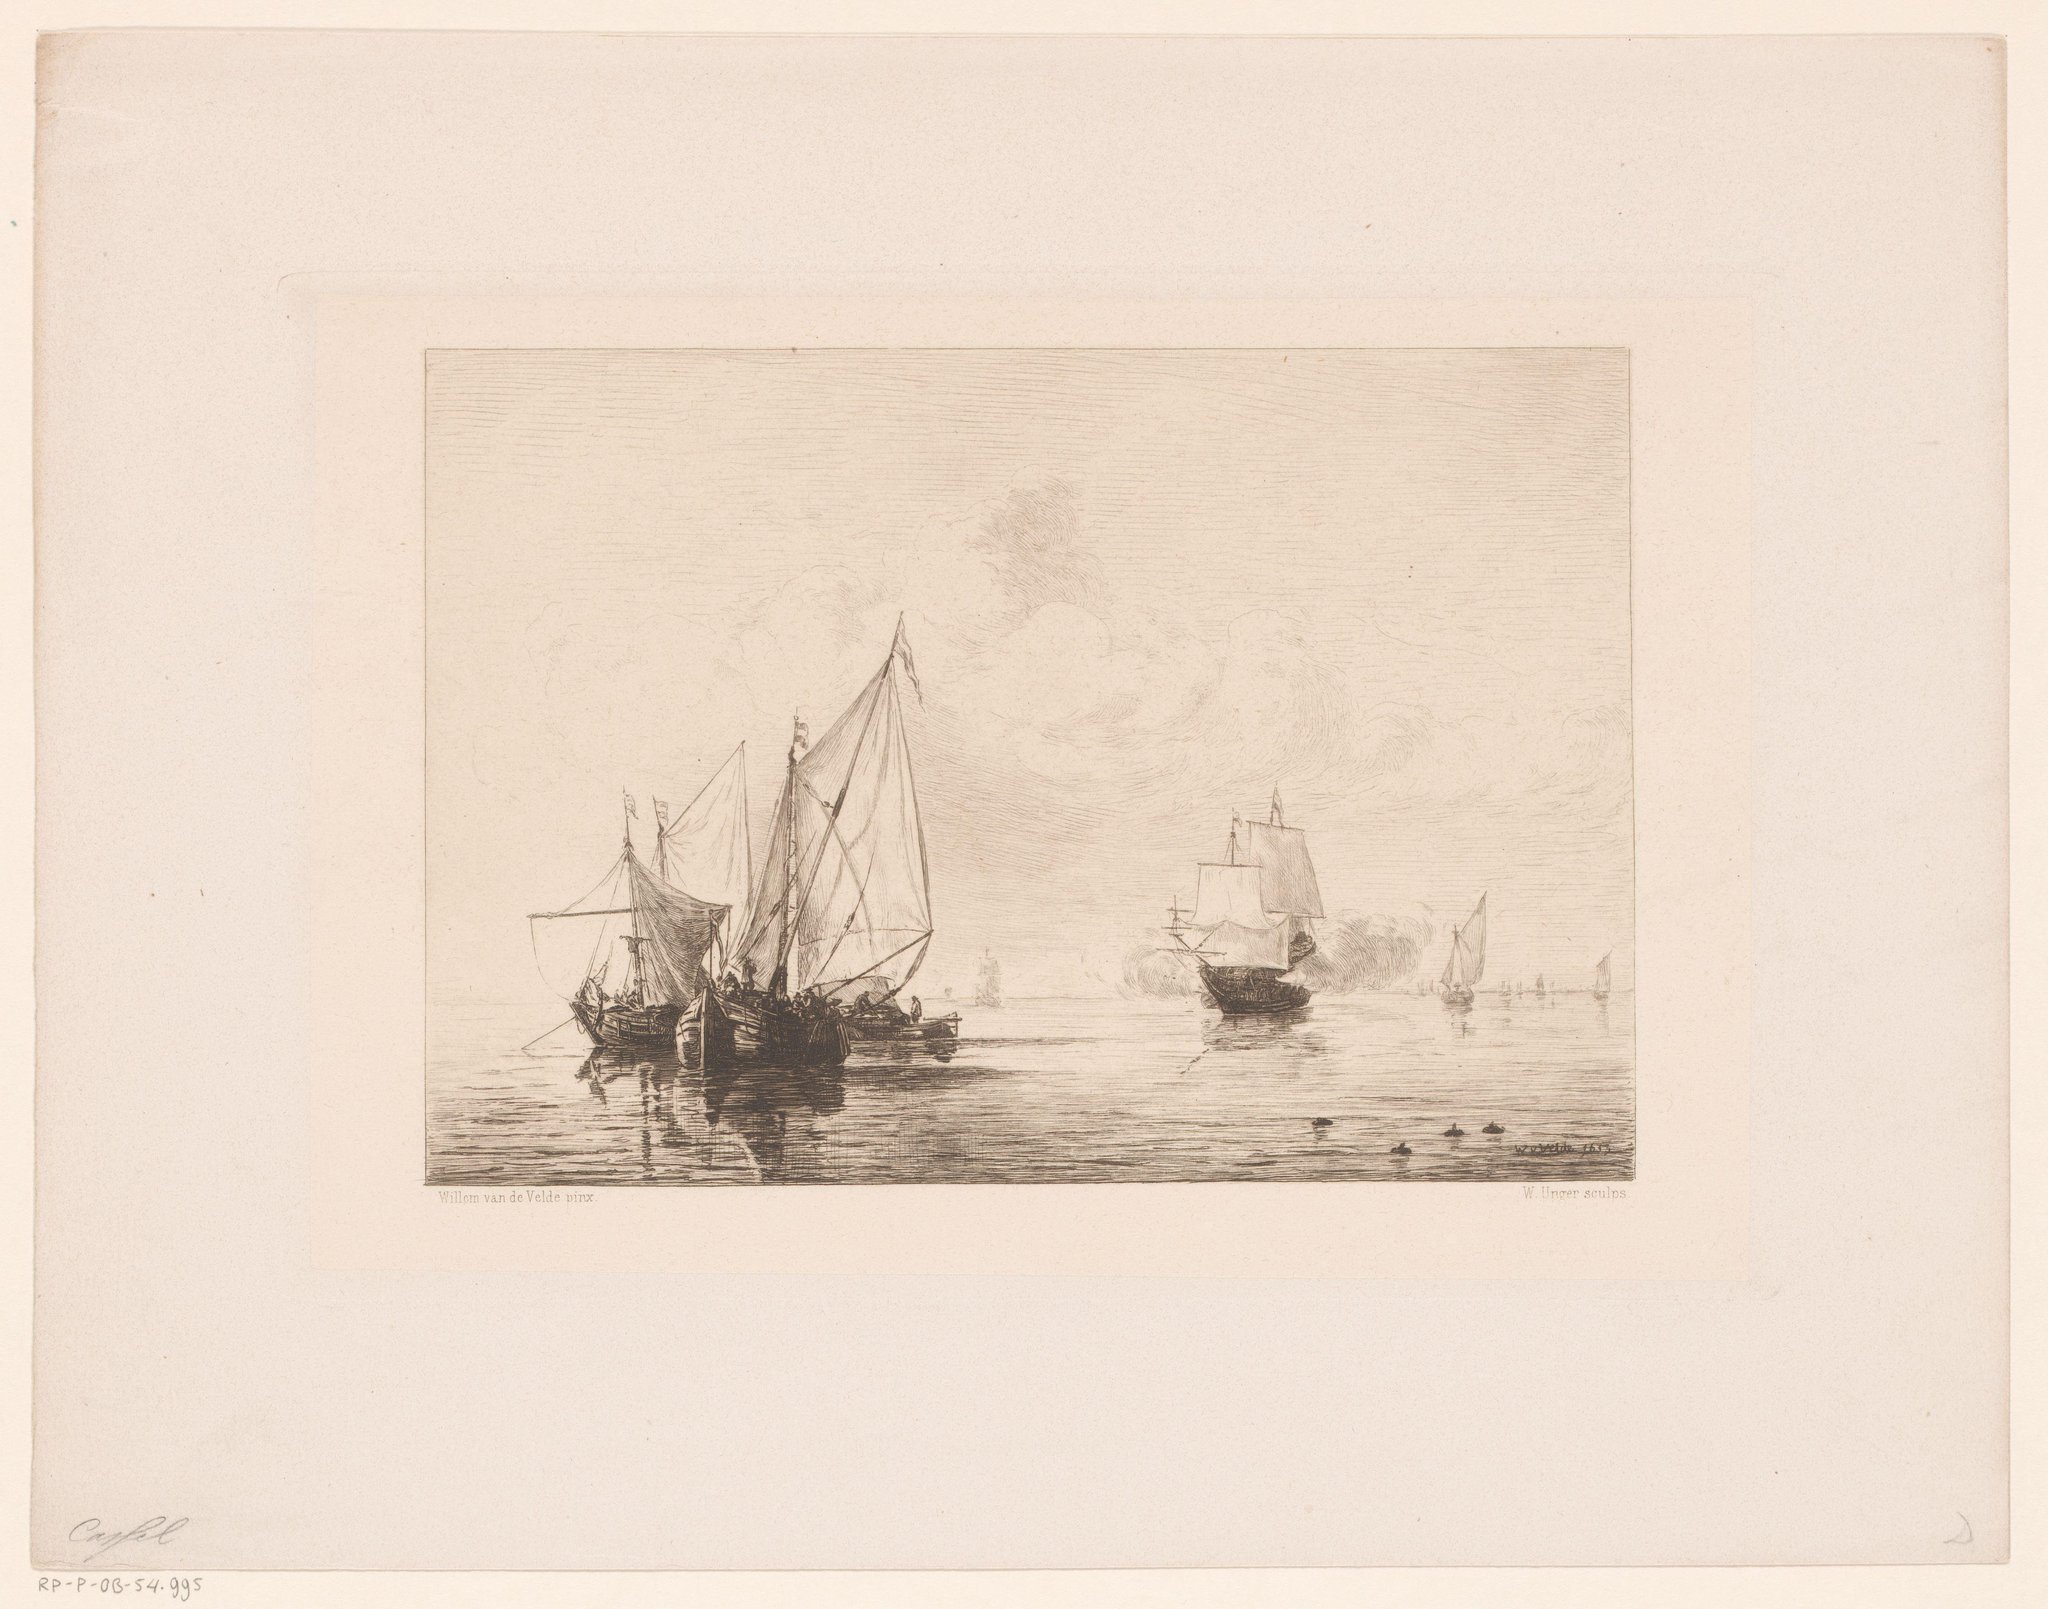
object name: print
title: Schepen op zee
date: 1847-1889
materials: paper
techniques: etching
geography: germany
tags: sailing-ship, sailing-boat, landscapes with waters, waterscapes, seascapes (in the temperate zone)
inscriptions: collector's mark: Lugt 2228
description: Prent naar het schilderij door Willem van de Velde II in de Gemäldegalerie Alte Meister te Kassel (inv.nr. GK 420).